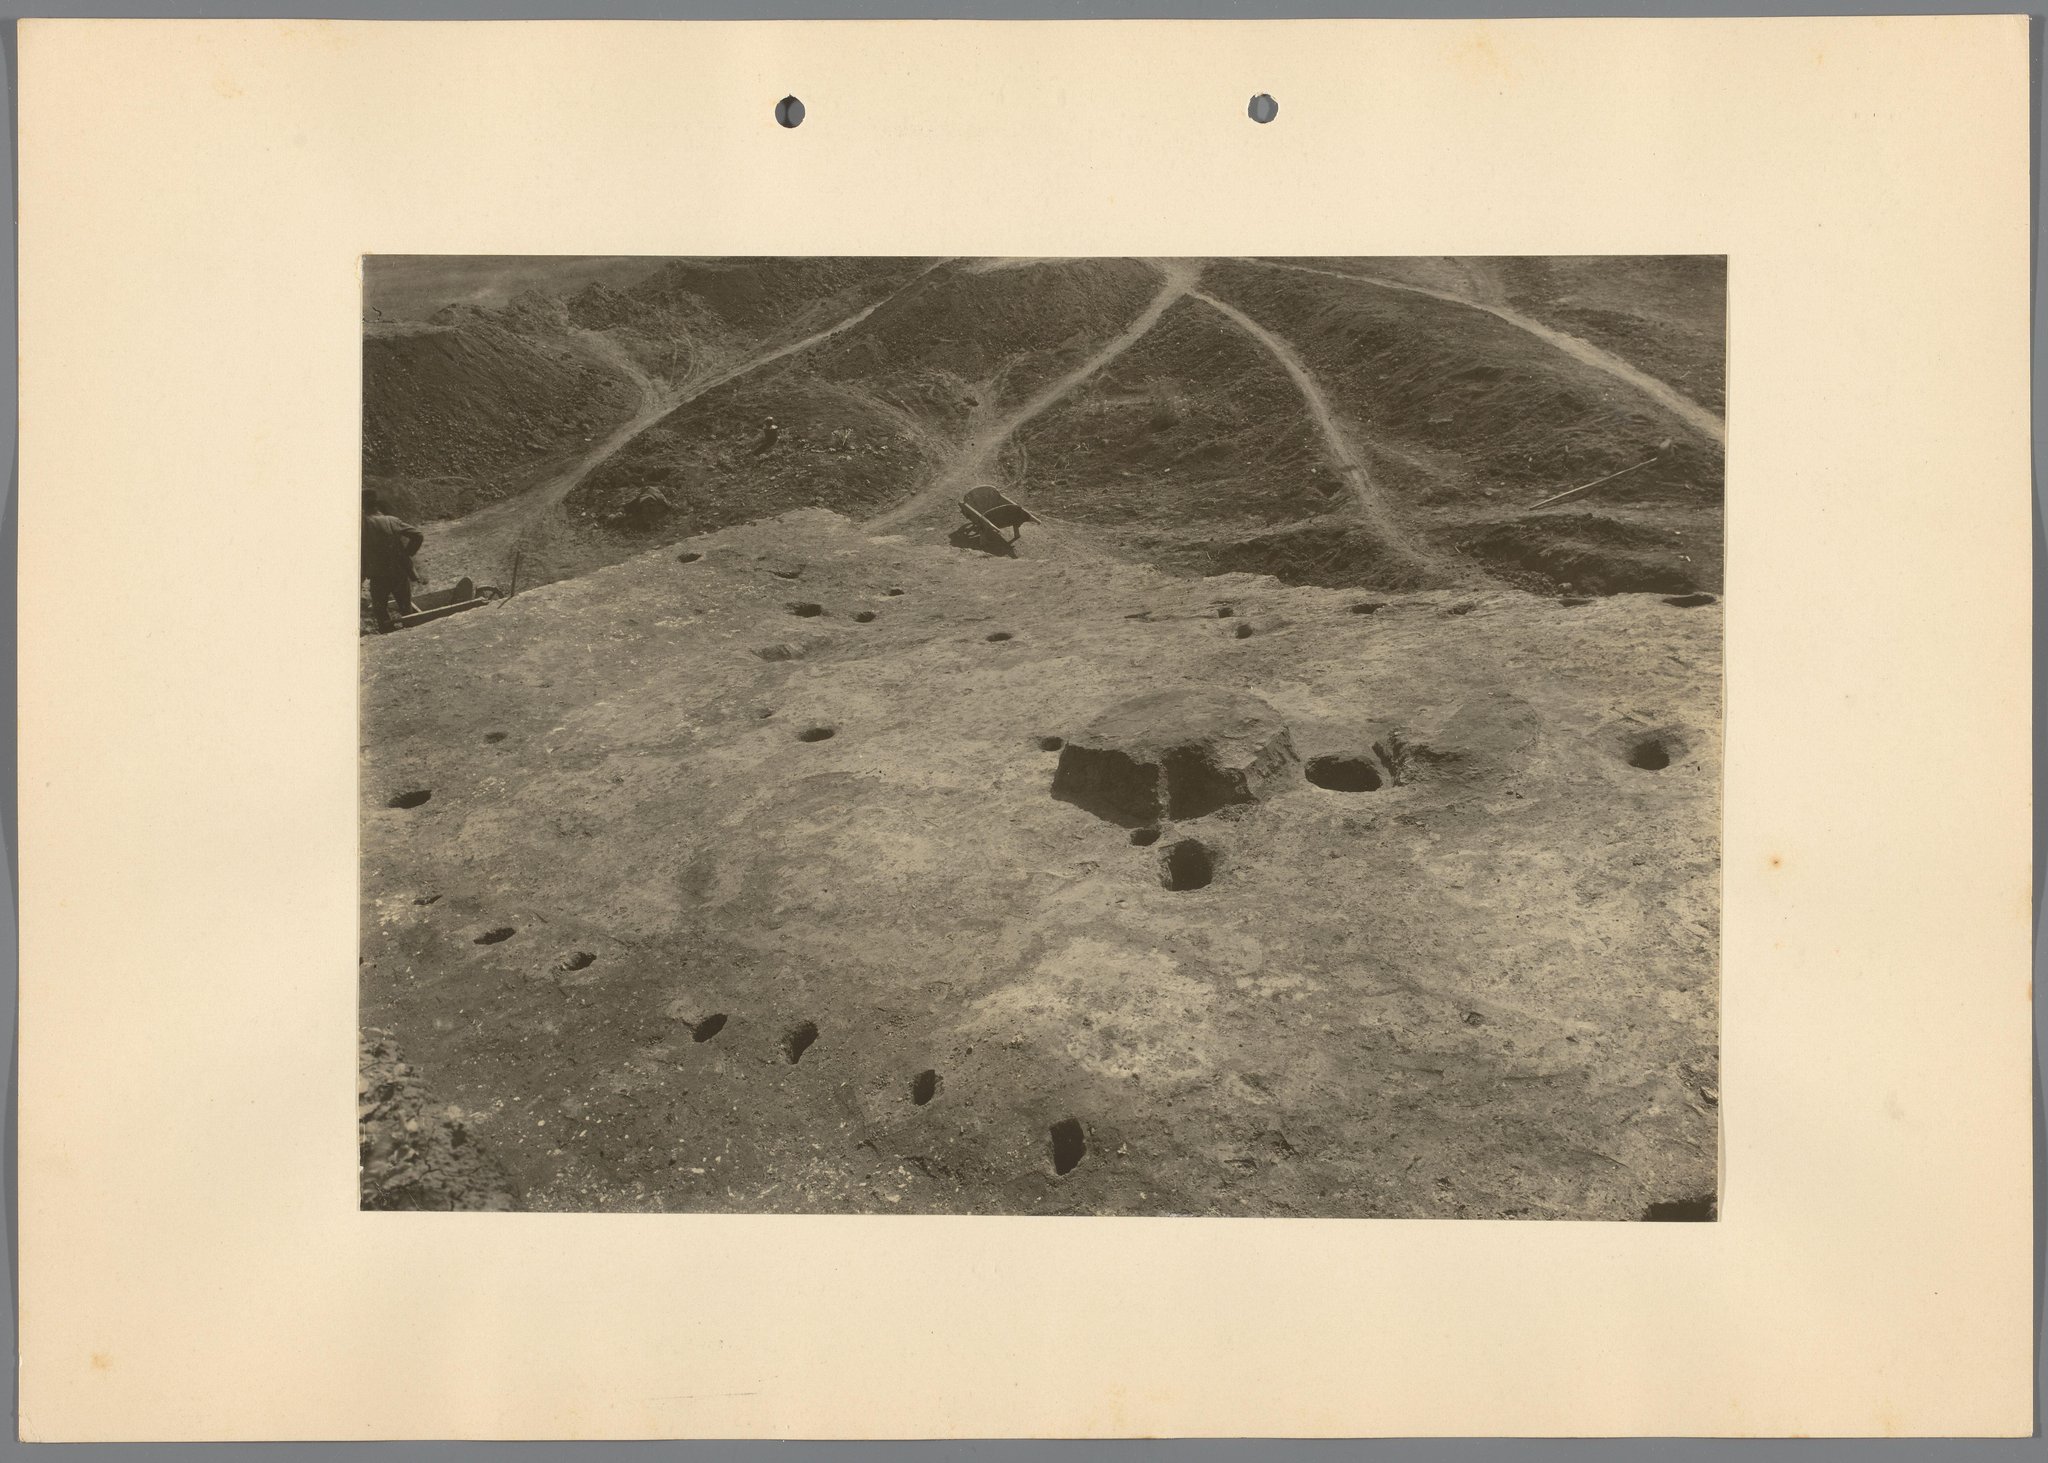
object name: photograph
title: Hollandsche Archaeologische Expeditie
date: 1928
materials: paper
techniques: gelatin silver print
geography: hungary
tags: wheelbarrow, excavation ~ archaeology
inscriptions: inscription: ‘Hollandsche Archaeologische Expeditie’